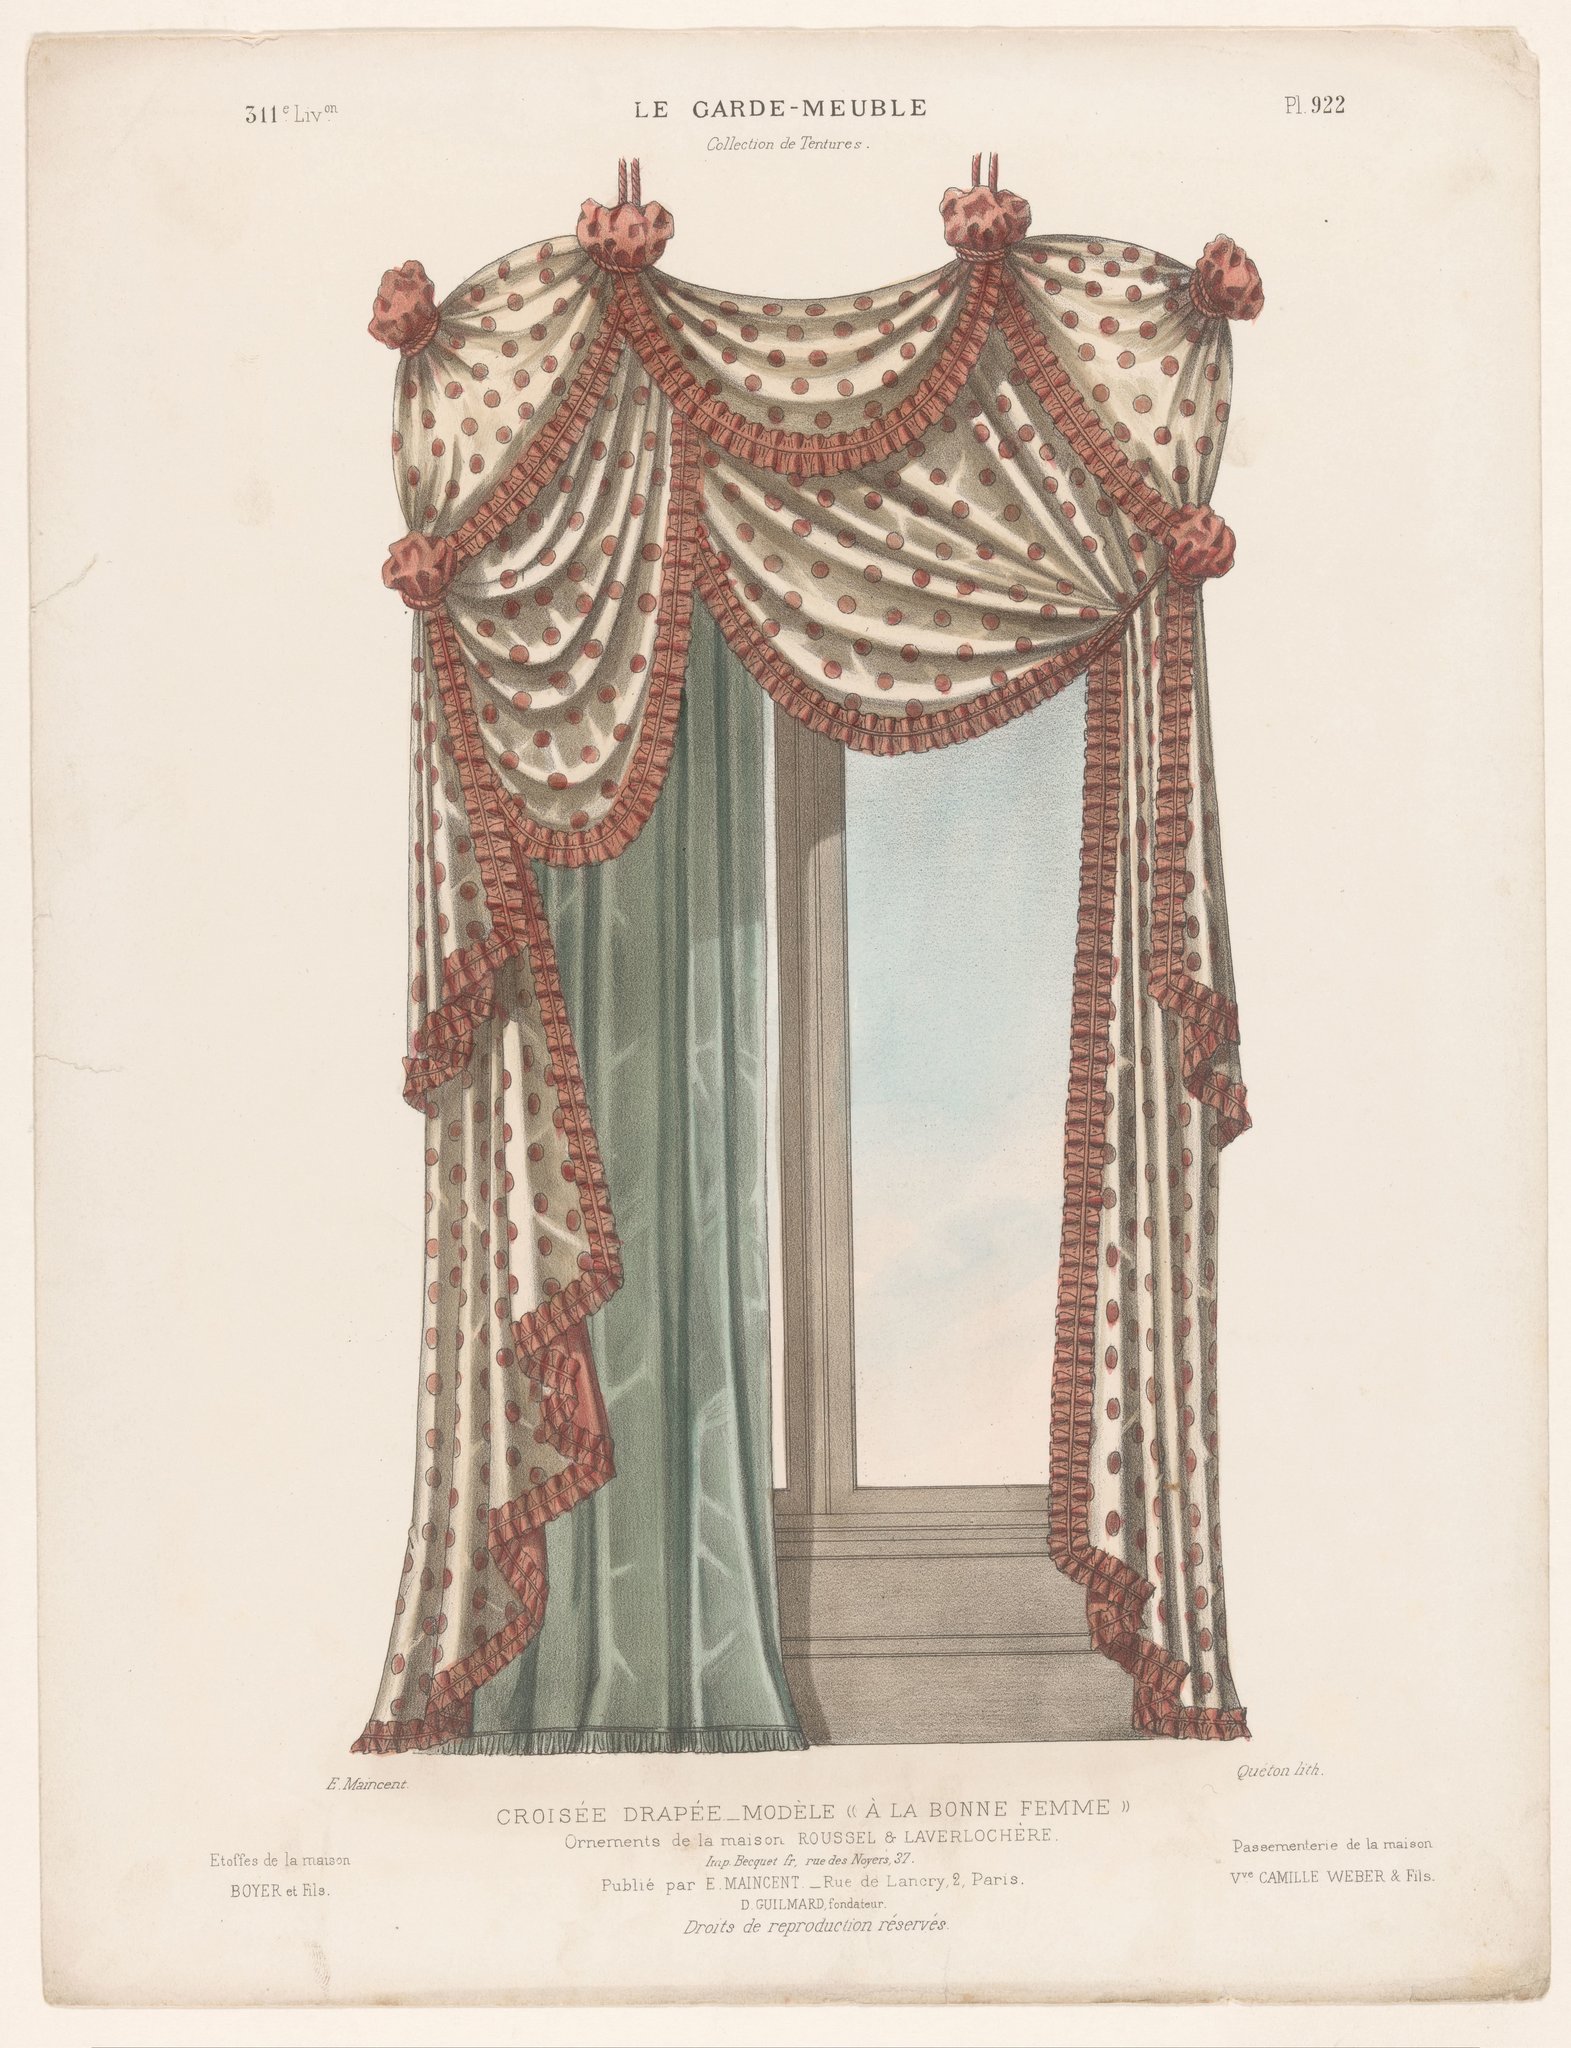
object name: print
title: Le Garde-Meuble / Collection de Tentures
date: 1885-1895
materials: paper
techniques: hand coloring, lithograph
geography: paris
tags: window, hangings and drapery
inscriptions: : ‘Droits de reproduction réservés.’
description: Kruisvenster met gedrapeerde gordijnen. Prent uit 311e Livraison.